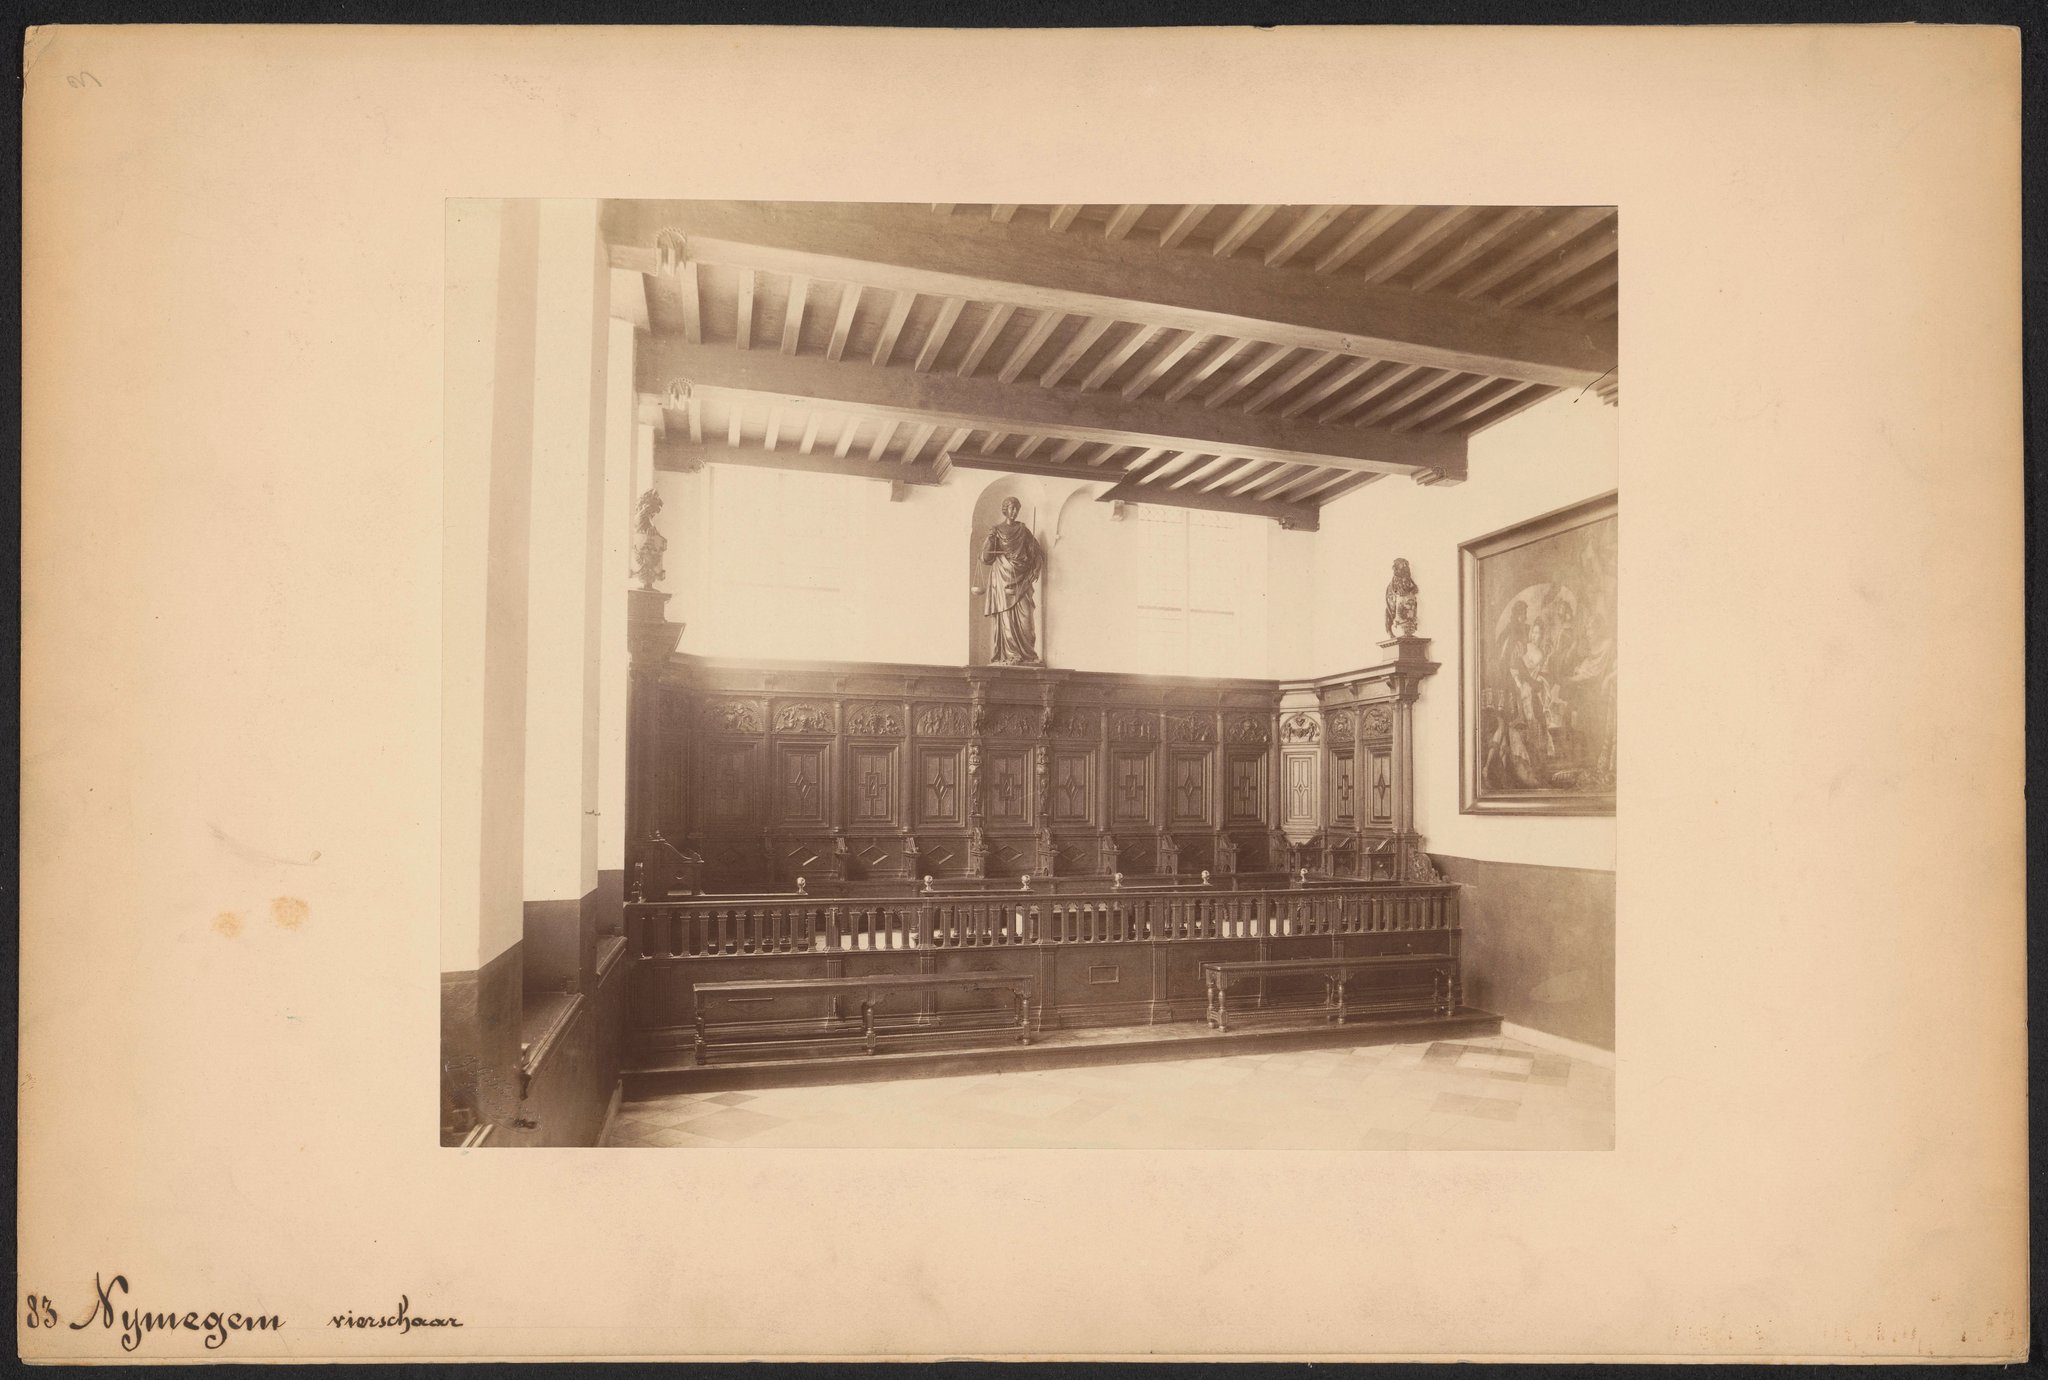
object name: photograph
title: Vierschaar met de Rechtvaardigheid in het stadhuis van Nijmegen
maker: johannes gerardus kramer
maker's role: fotograaf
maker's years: 1845-1903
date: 1875-1900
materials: cardboard, photographic support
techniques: albumen print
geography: nijmegen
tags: political tribunal (+ court room), justitia (justice) as roman personification, townhall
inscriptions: name: ‘J.G. Kramer Groningen’, number: ‘83’, collector's mark: Lugt 3937, annotation:, inscription: ‘Nijmegen vierschaar’